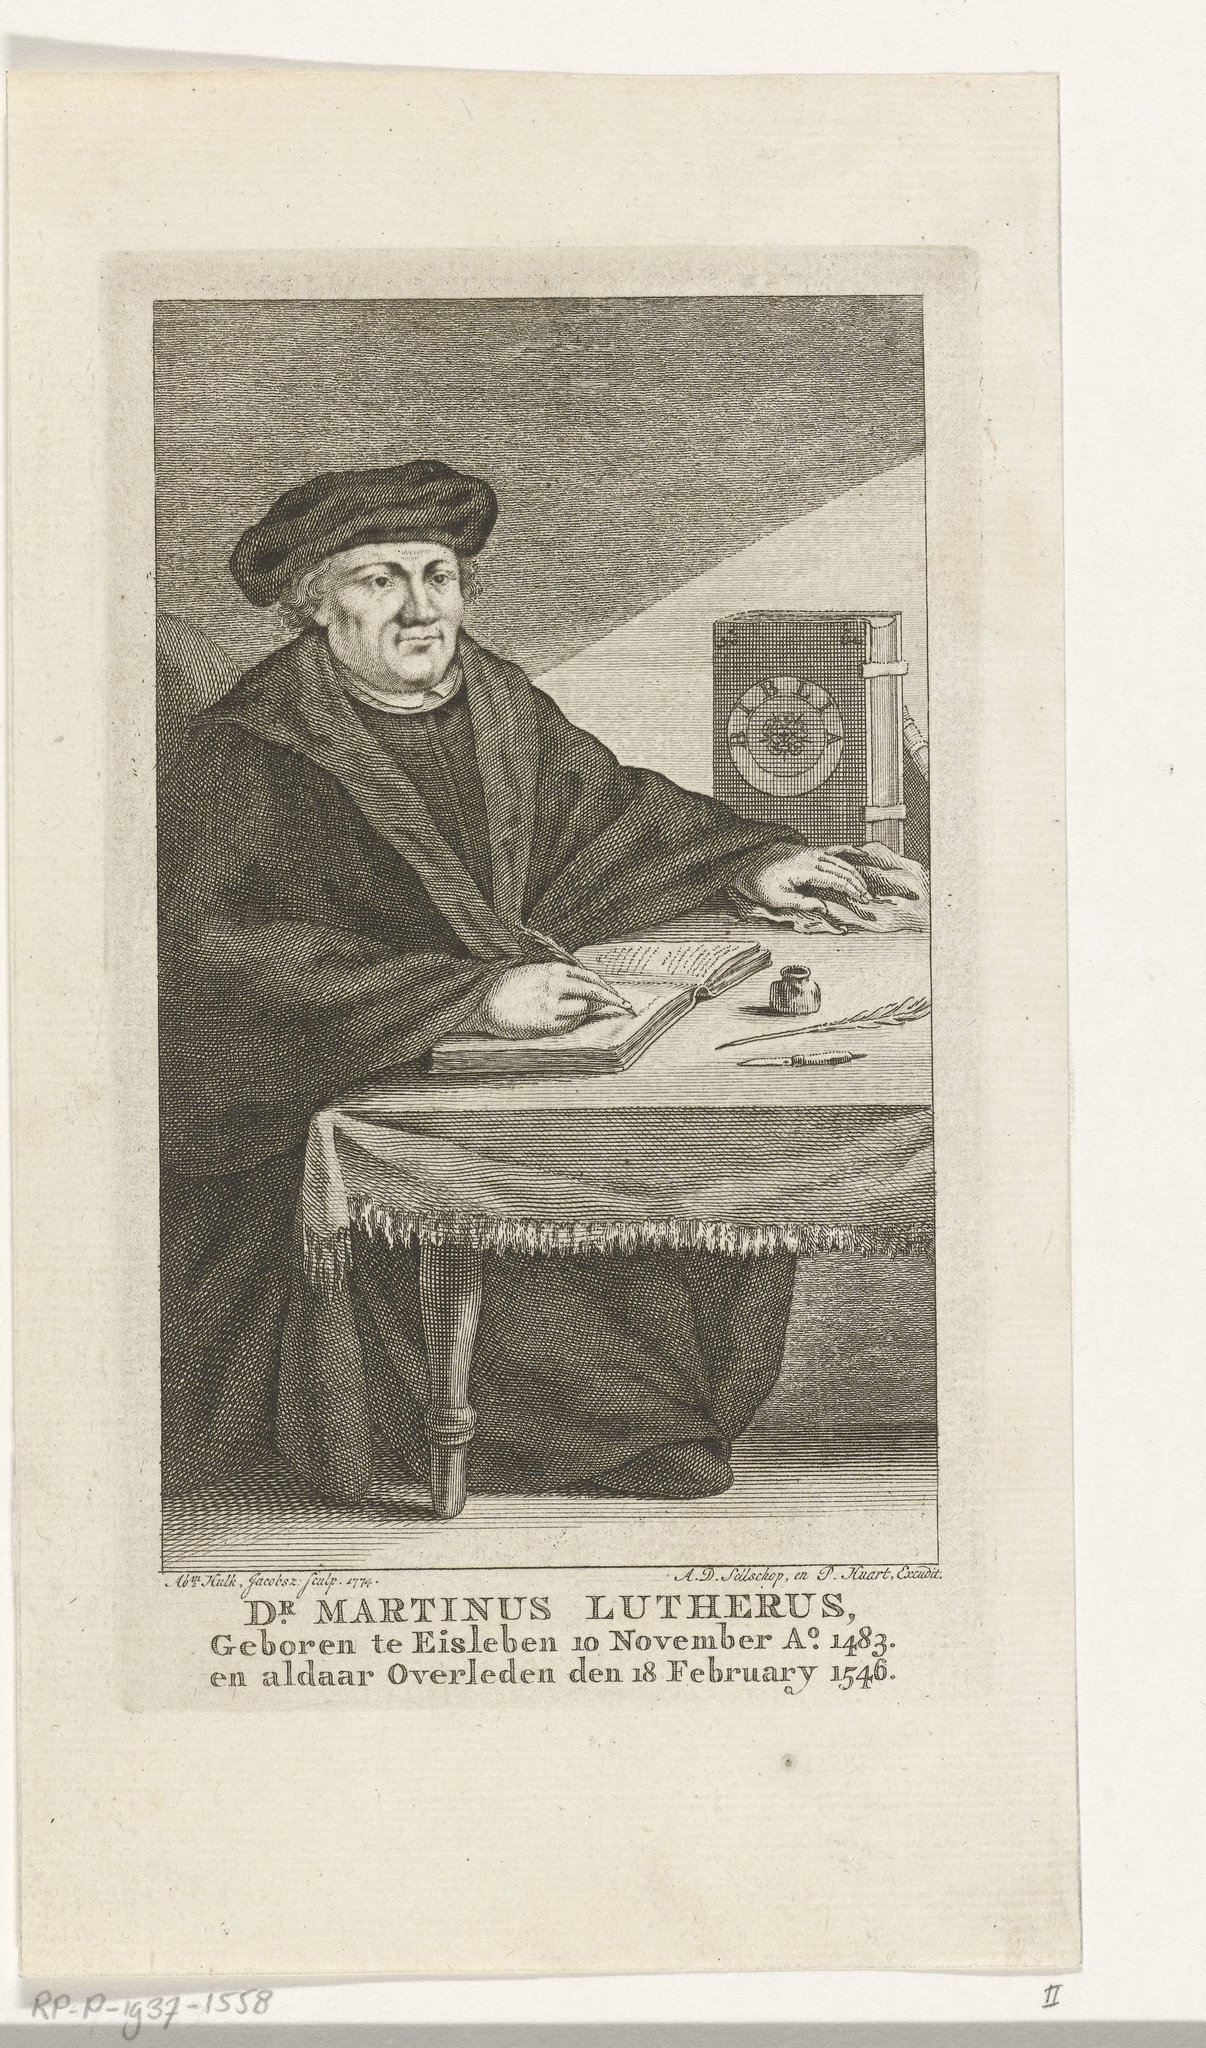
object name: print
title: Portret van Martin Luther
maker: abraham jacobsz. hulk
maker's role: print maker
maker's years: 1751-1817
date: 1774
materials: paper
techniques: engraving, etching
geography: amsterdam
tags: priest, martin luther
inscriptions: collector's mark: Lugt 2228, collector's mark: Lugt 2760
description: Portret naar rechts ten voeten uit van Martin Luther, zittende en schrijvende aan een tafel. Op de tafel een rechtop staande Bijbel, een inktpot, veer en een pennenmes. Onder drie tekstregels in het Nederlands.